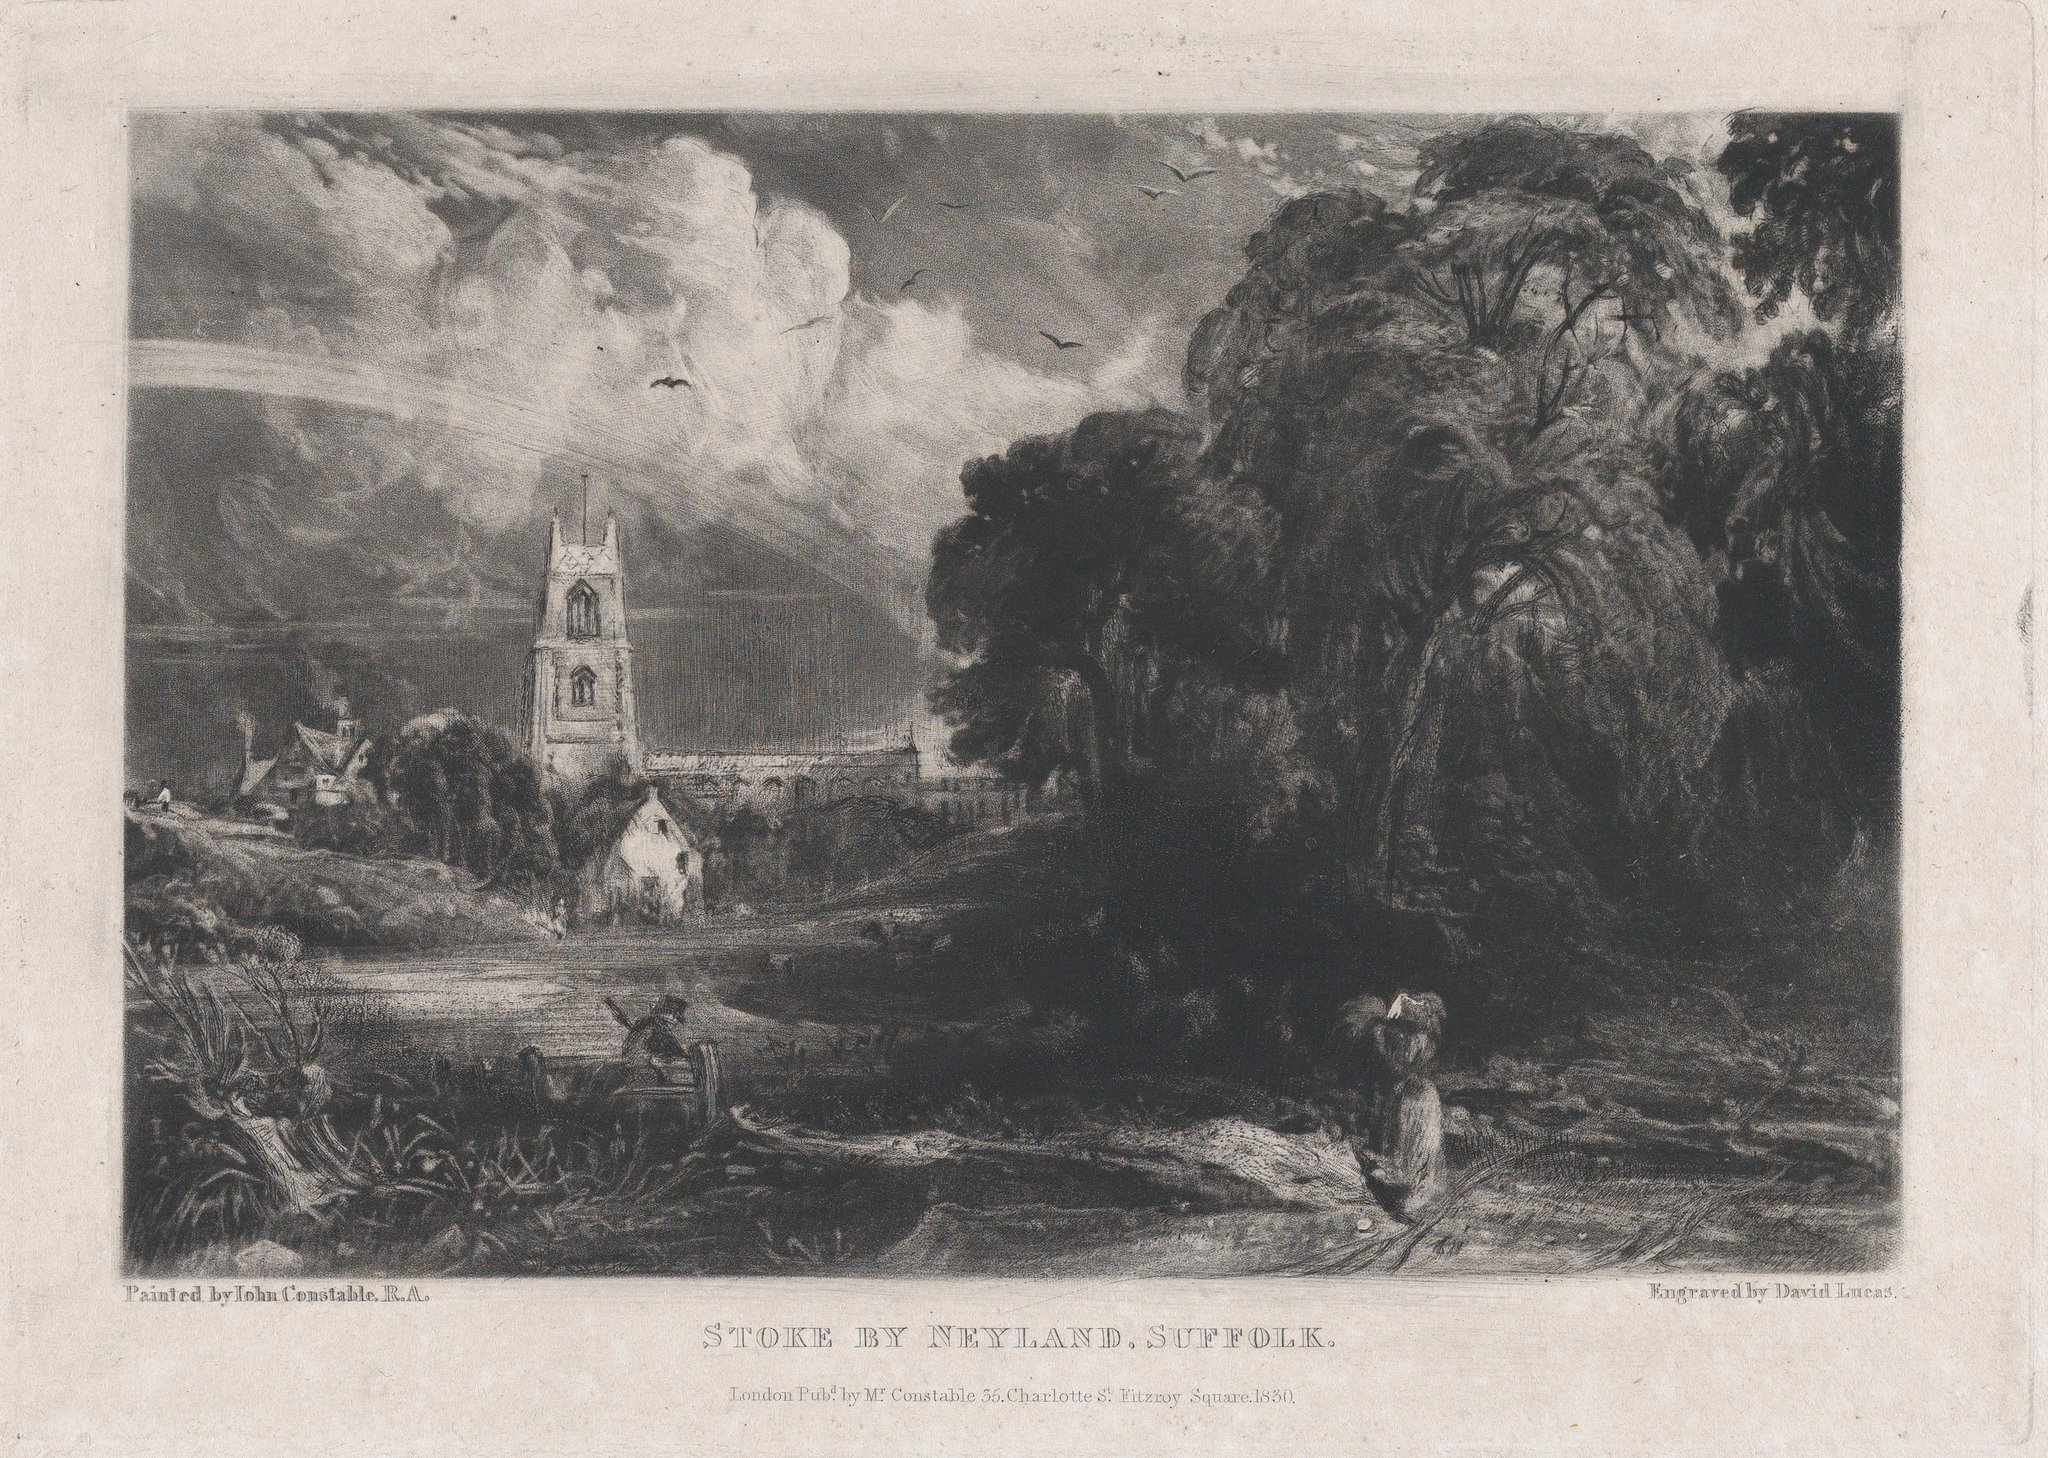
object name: print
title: Stoke-by-Neyland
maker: david lucas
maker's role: artist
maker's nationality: british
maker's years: 1802-1881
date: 1830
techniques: mezzotint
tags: towers,landscapes